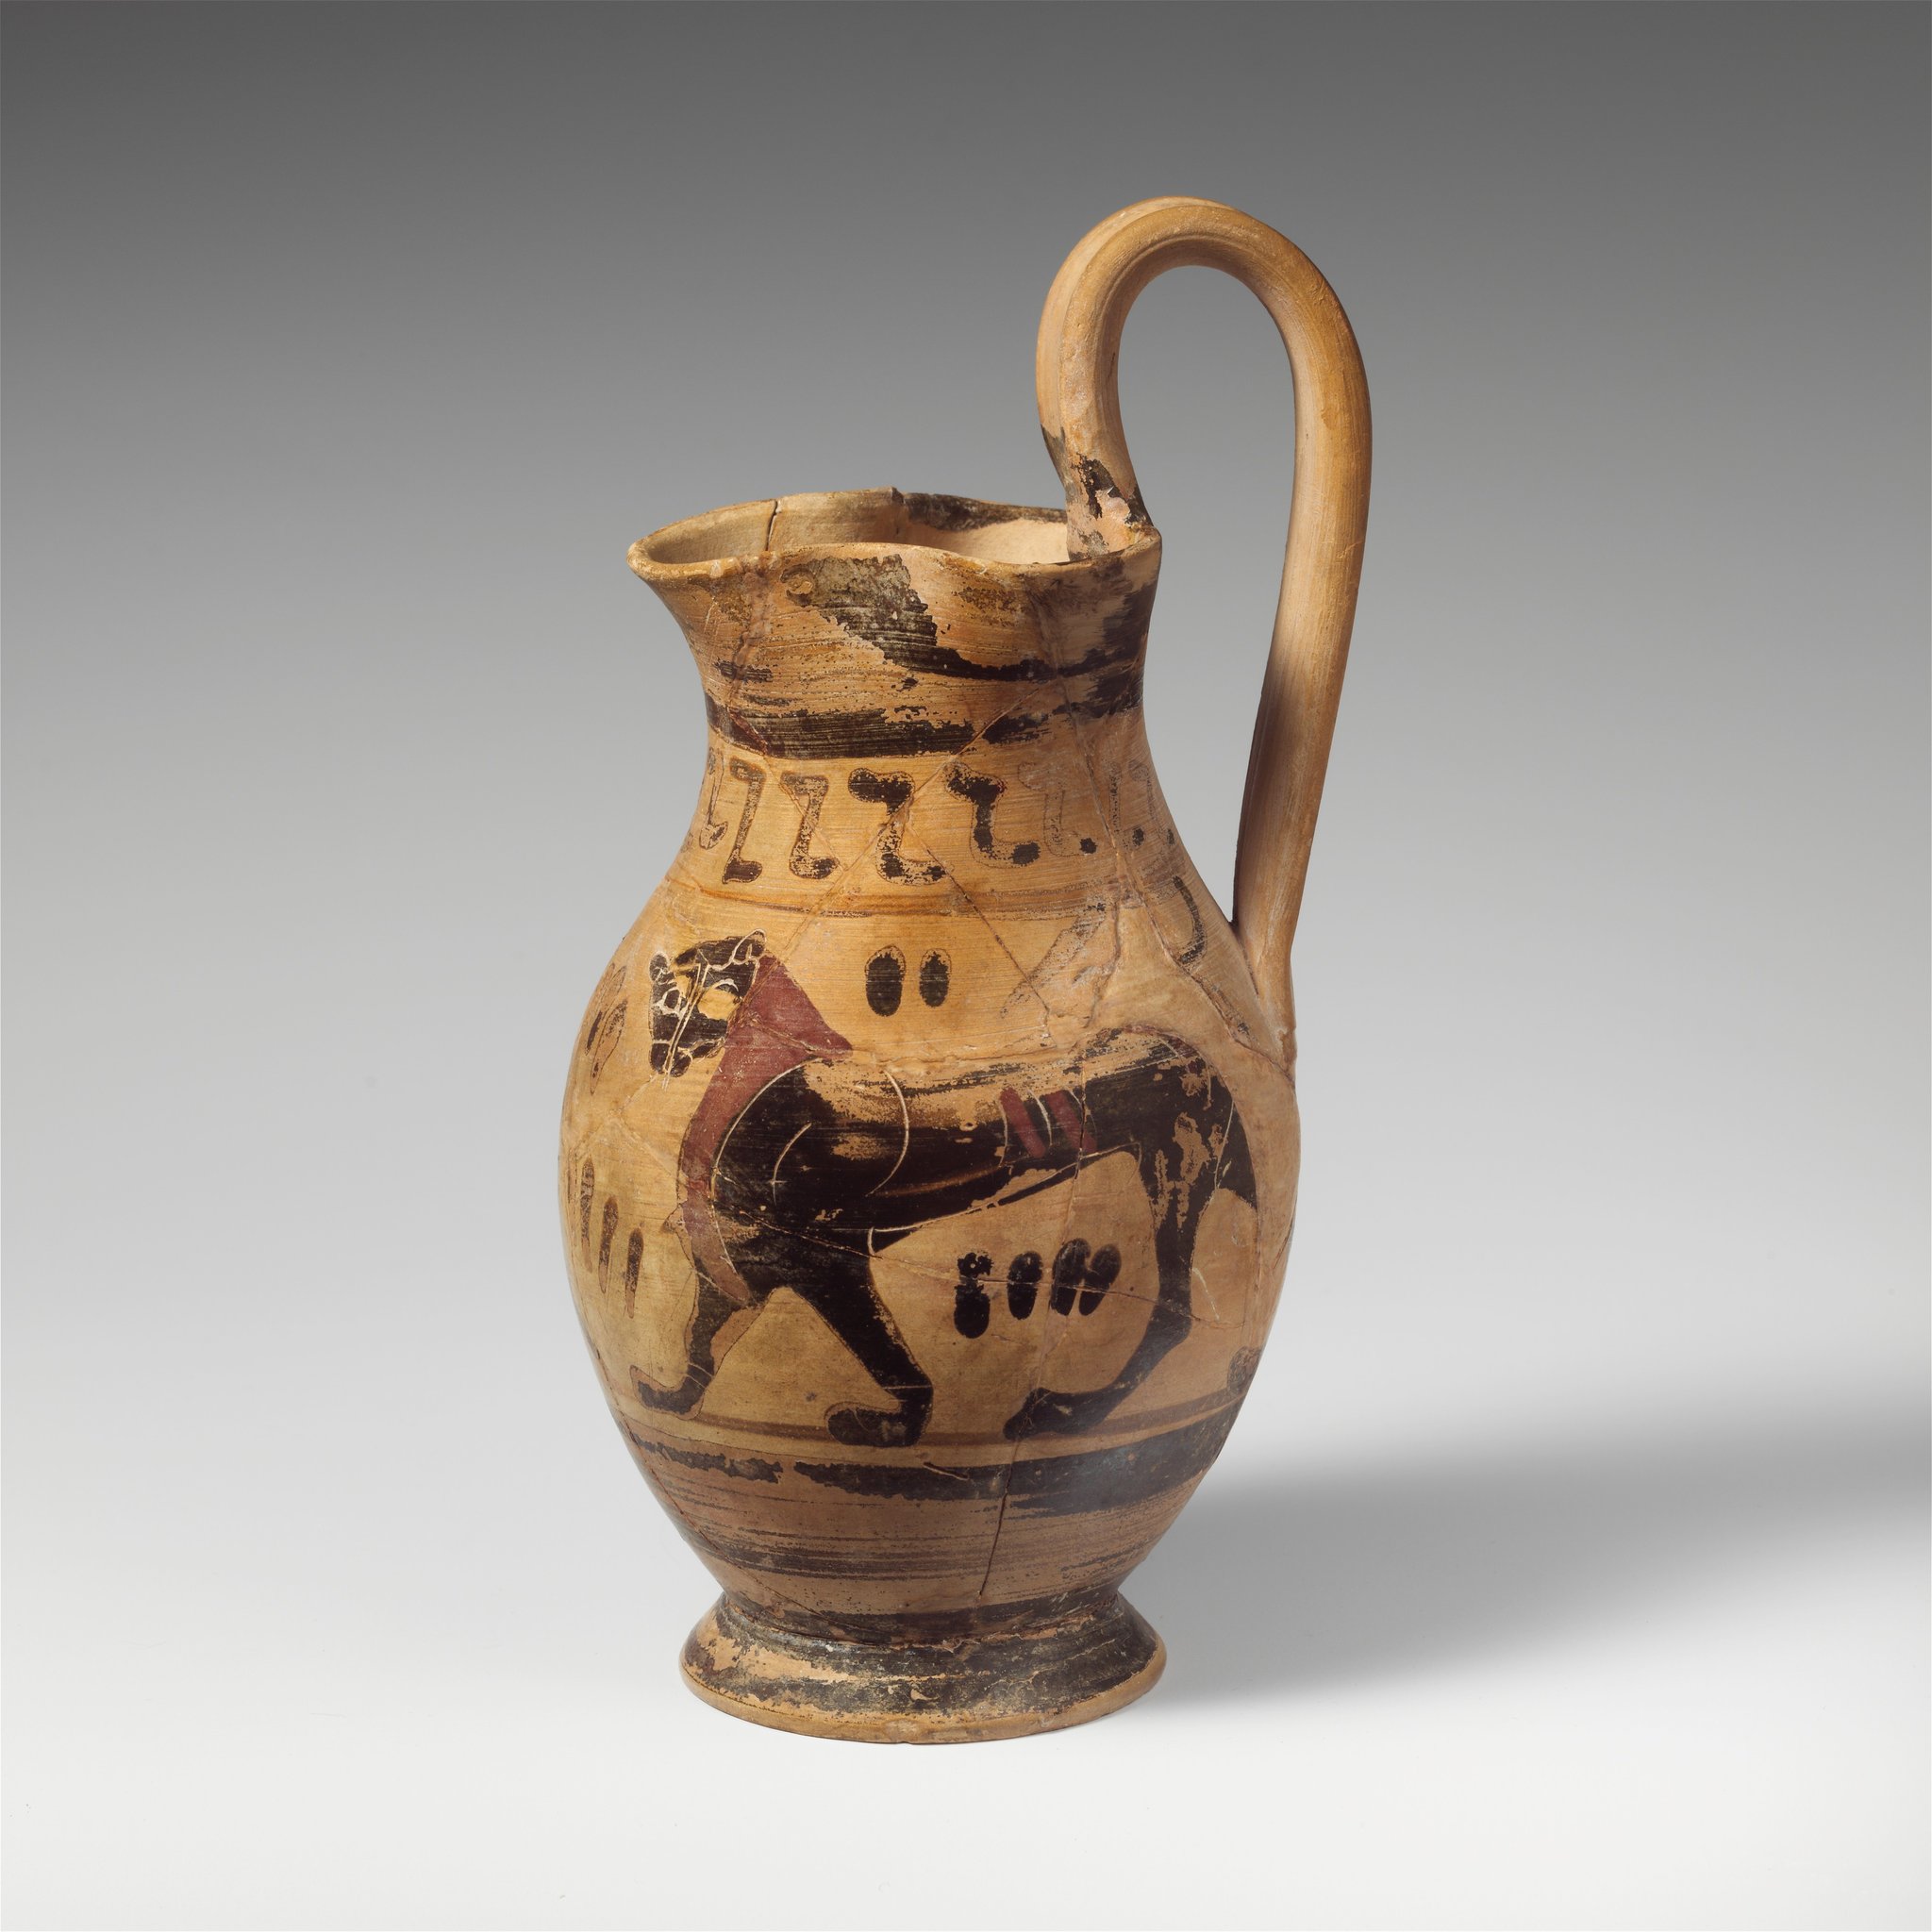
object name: olpe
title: Terracotta oinochoe: olpe (jug)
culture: greek, attic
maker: group of the early olpai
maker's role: artist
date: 600-551 BCE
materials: terracotta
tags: panthers